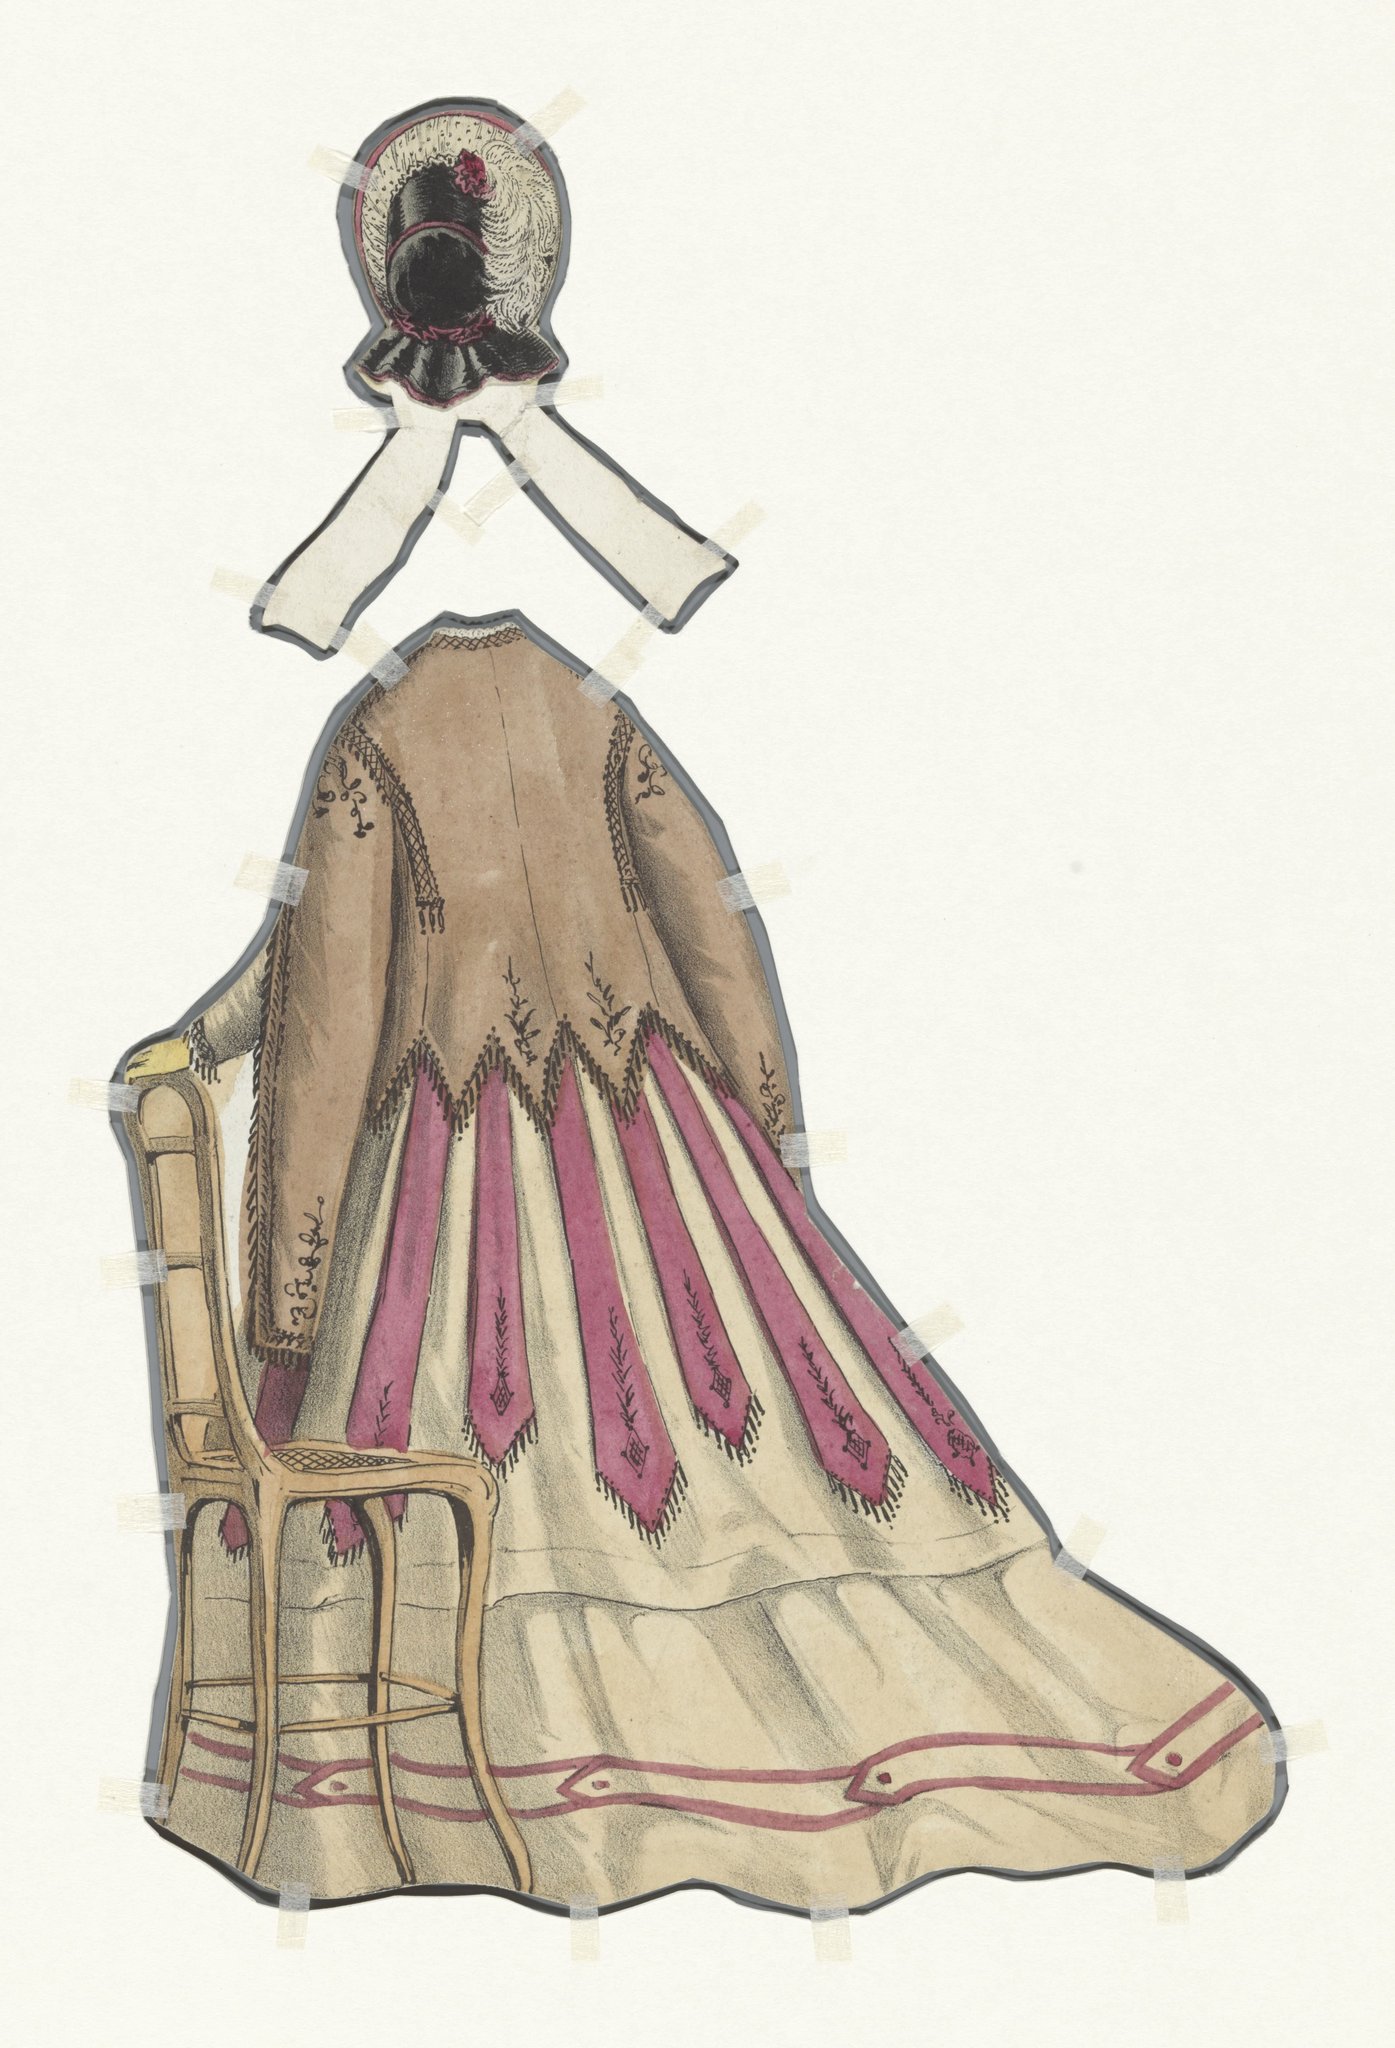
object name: fashion print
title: Achterzijde van een jurk voor een uitknippop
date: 1825-1875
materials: paper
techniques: engraving, hand coloring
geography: paris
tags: fashion plates